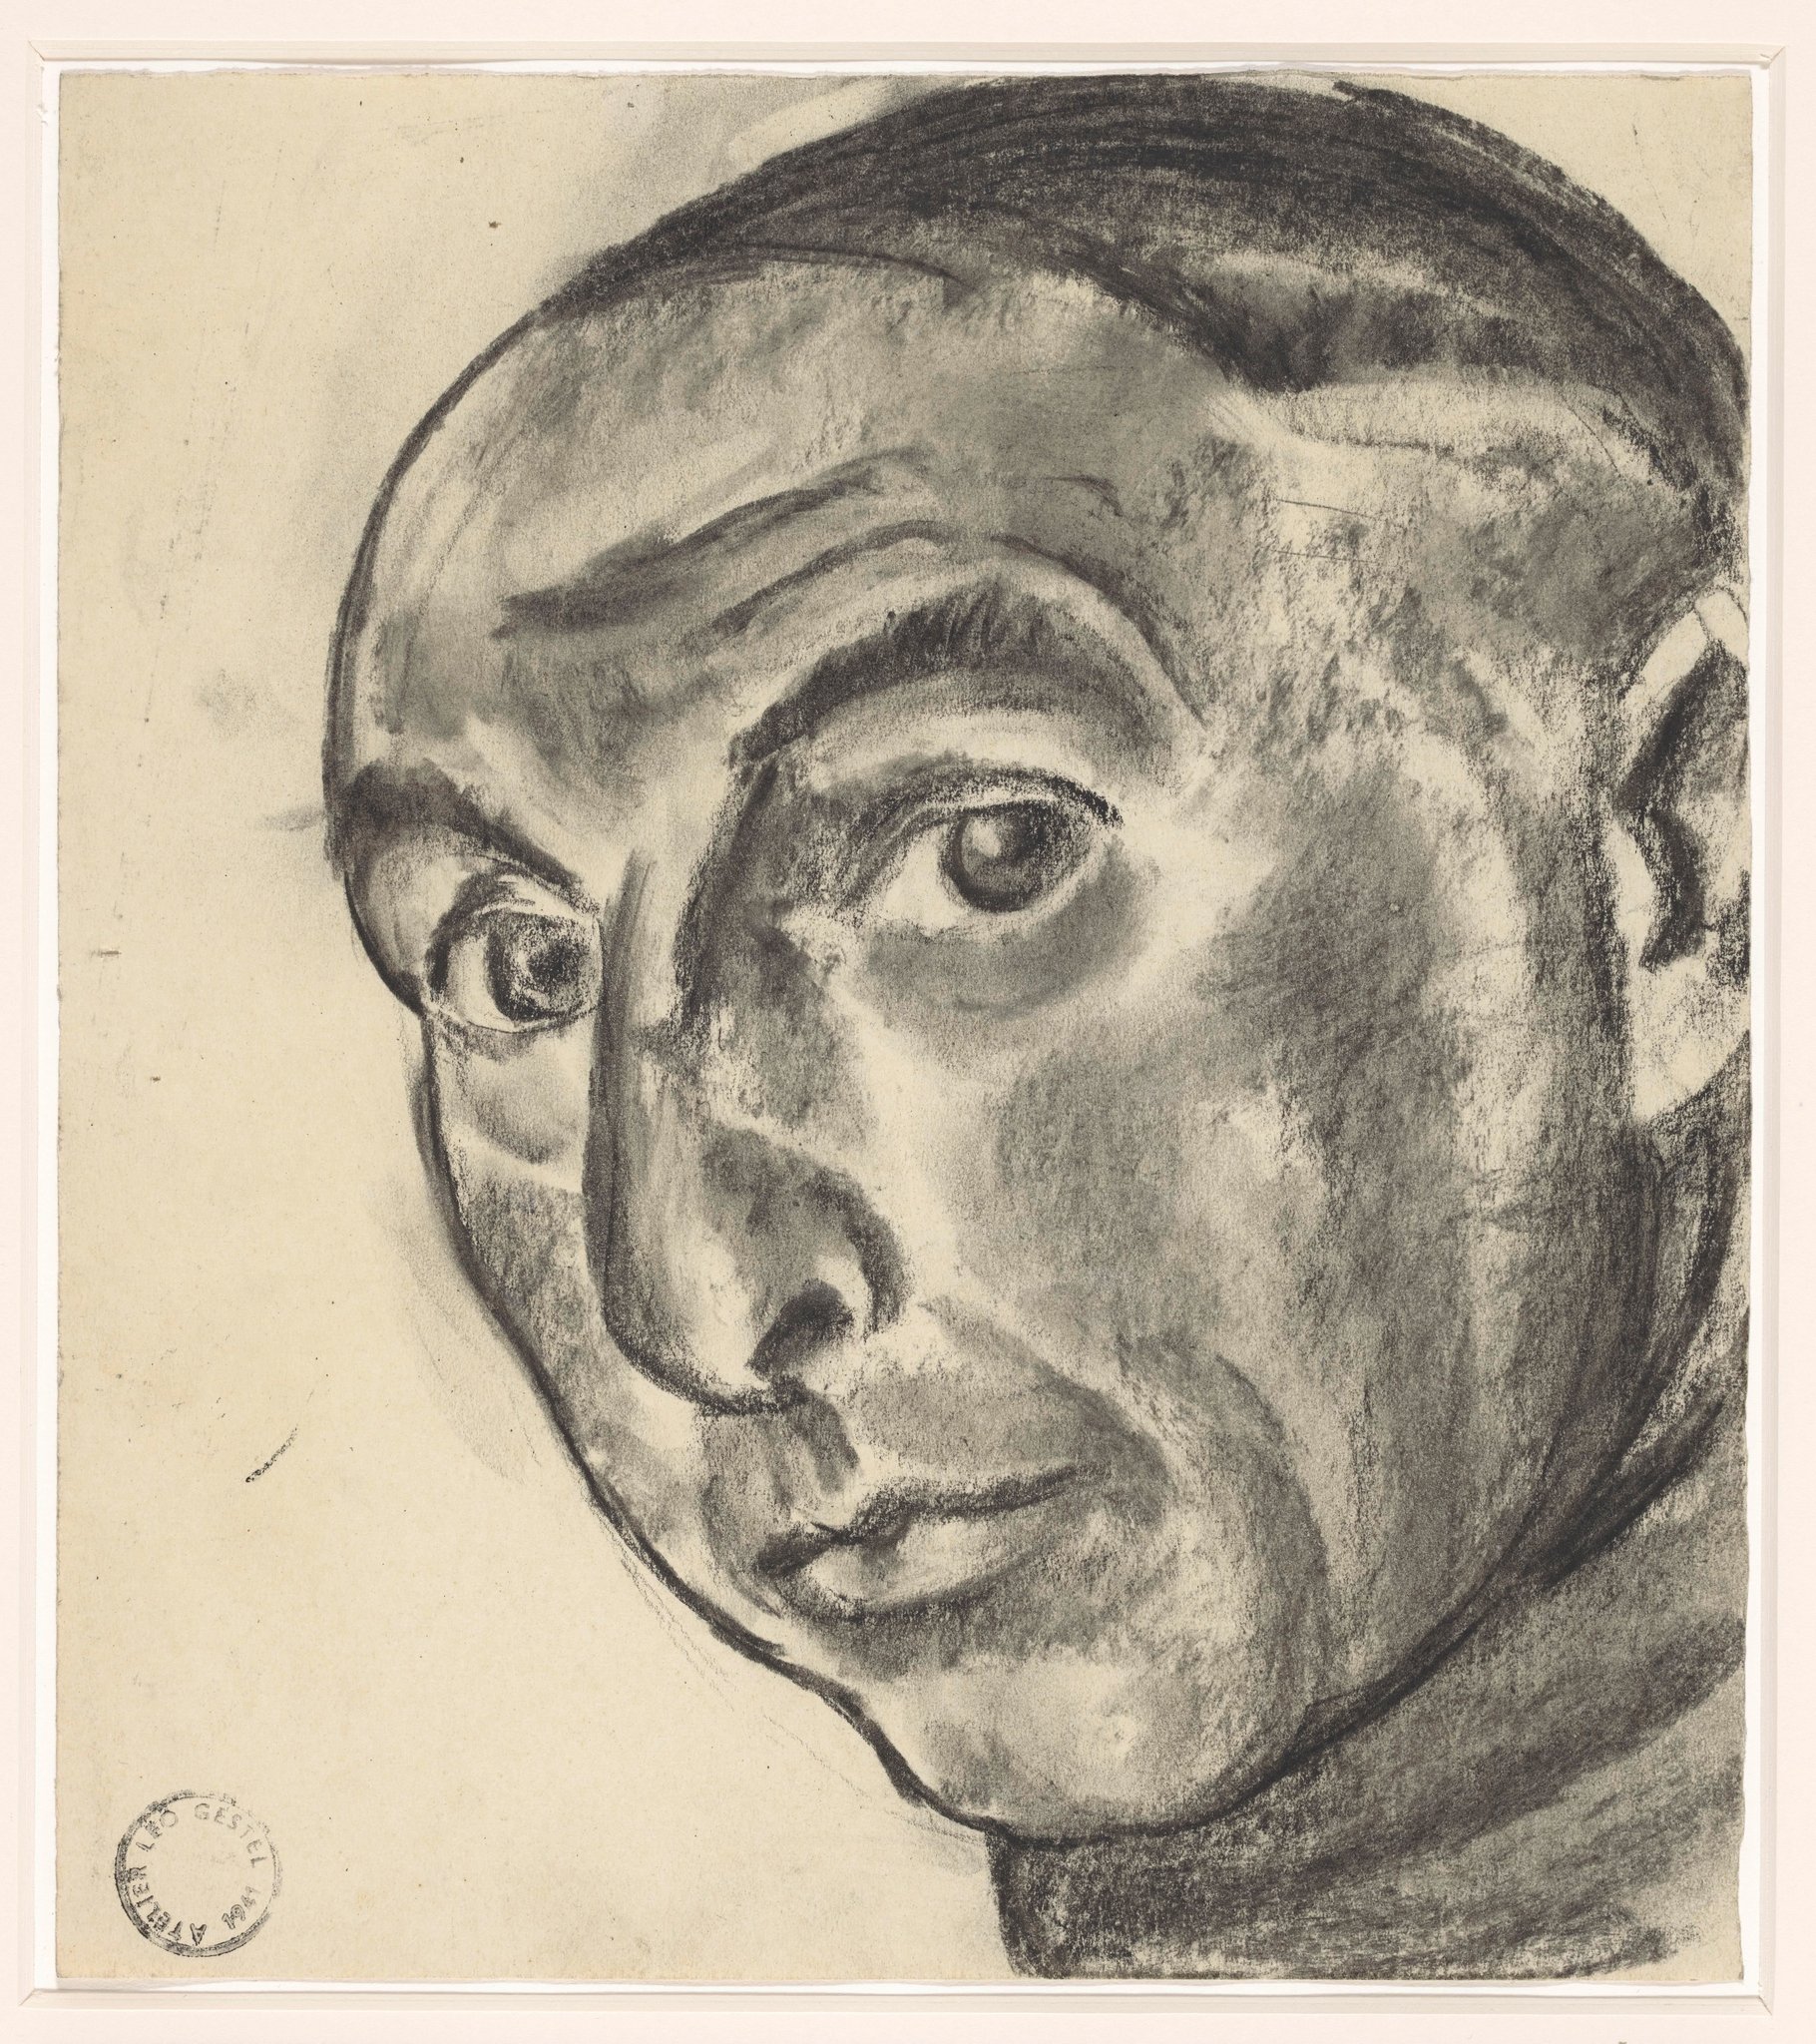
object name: drawing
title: Zelfportret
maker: leo gestel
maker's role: draughtsman, print maker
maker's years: 1881-1941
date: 1926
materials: charcoal, paper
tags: print maker, draughtsman, leo gestel, historical persons, portrait, self-portrait of painter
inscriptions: workshop stamp: ‘Atelier Leo Gestel 1941’